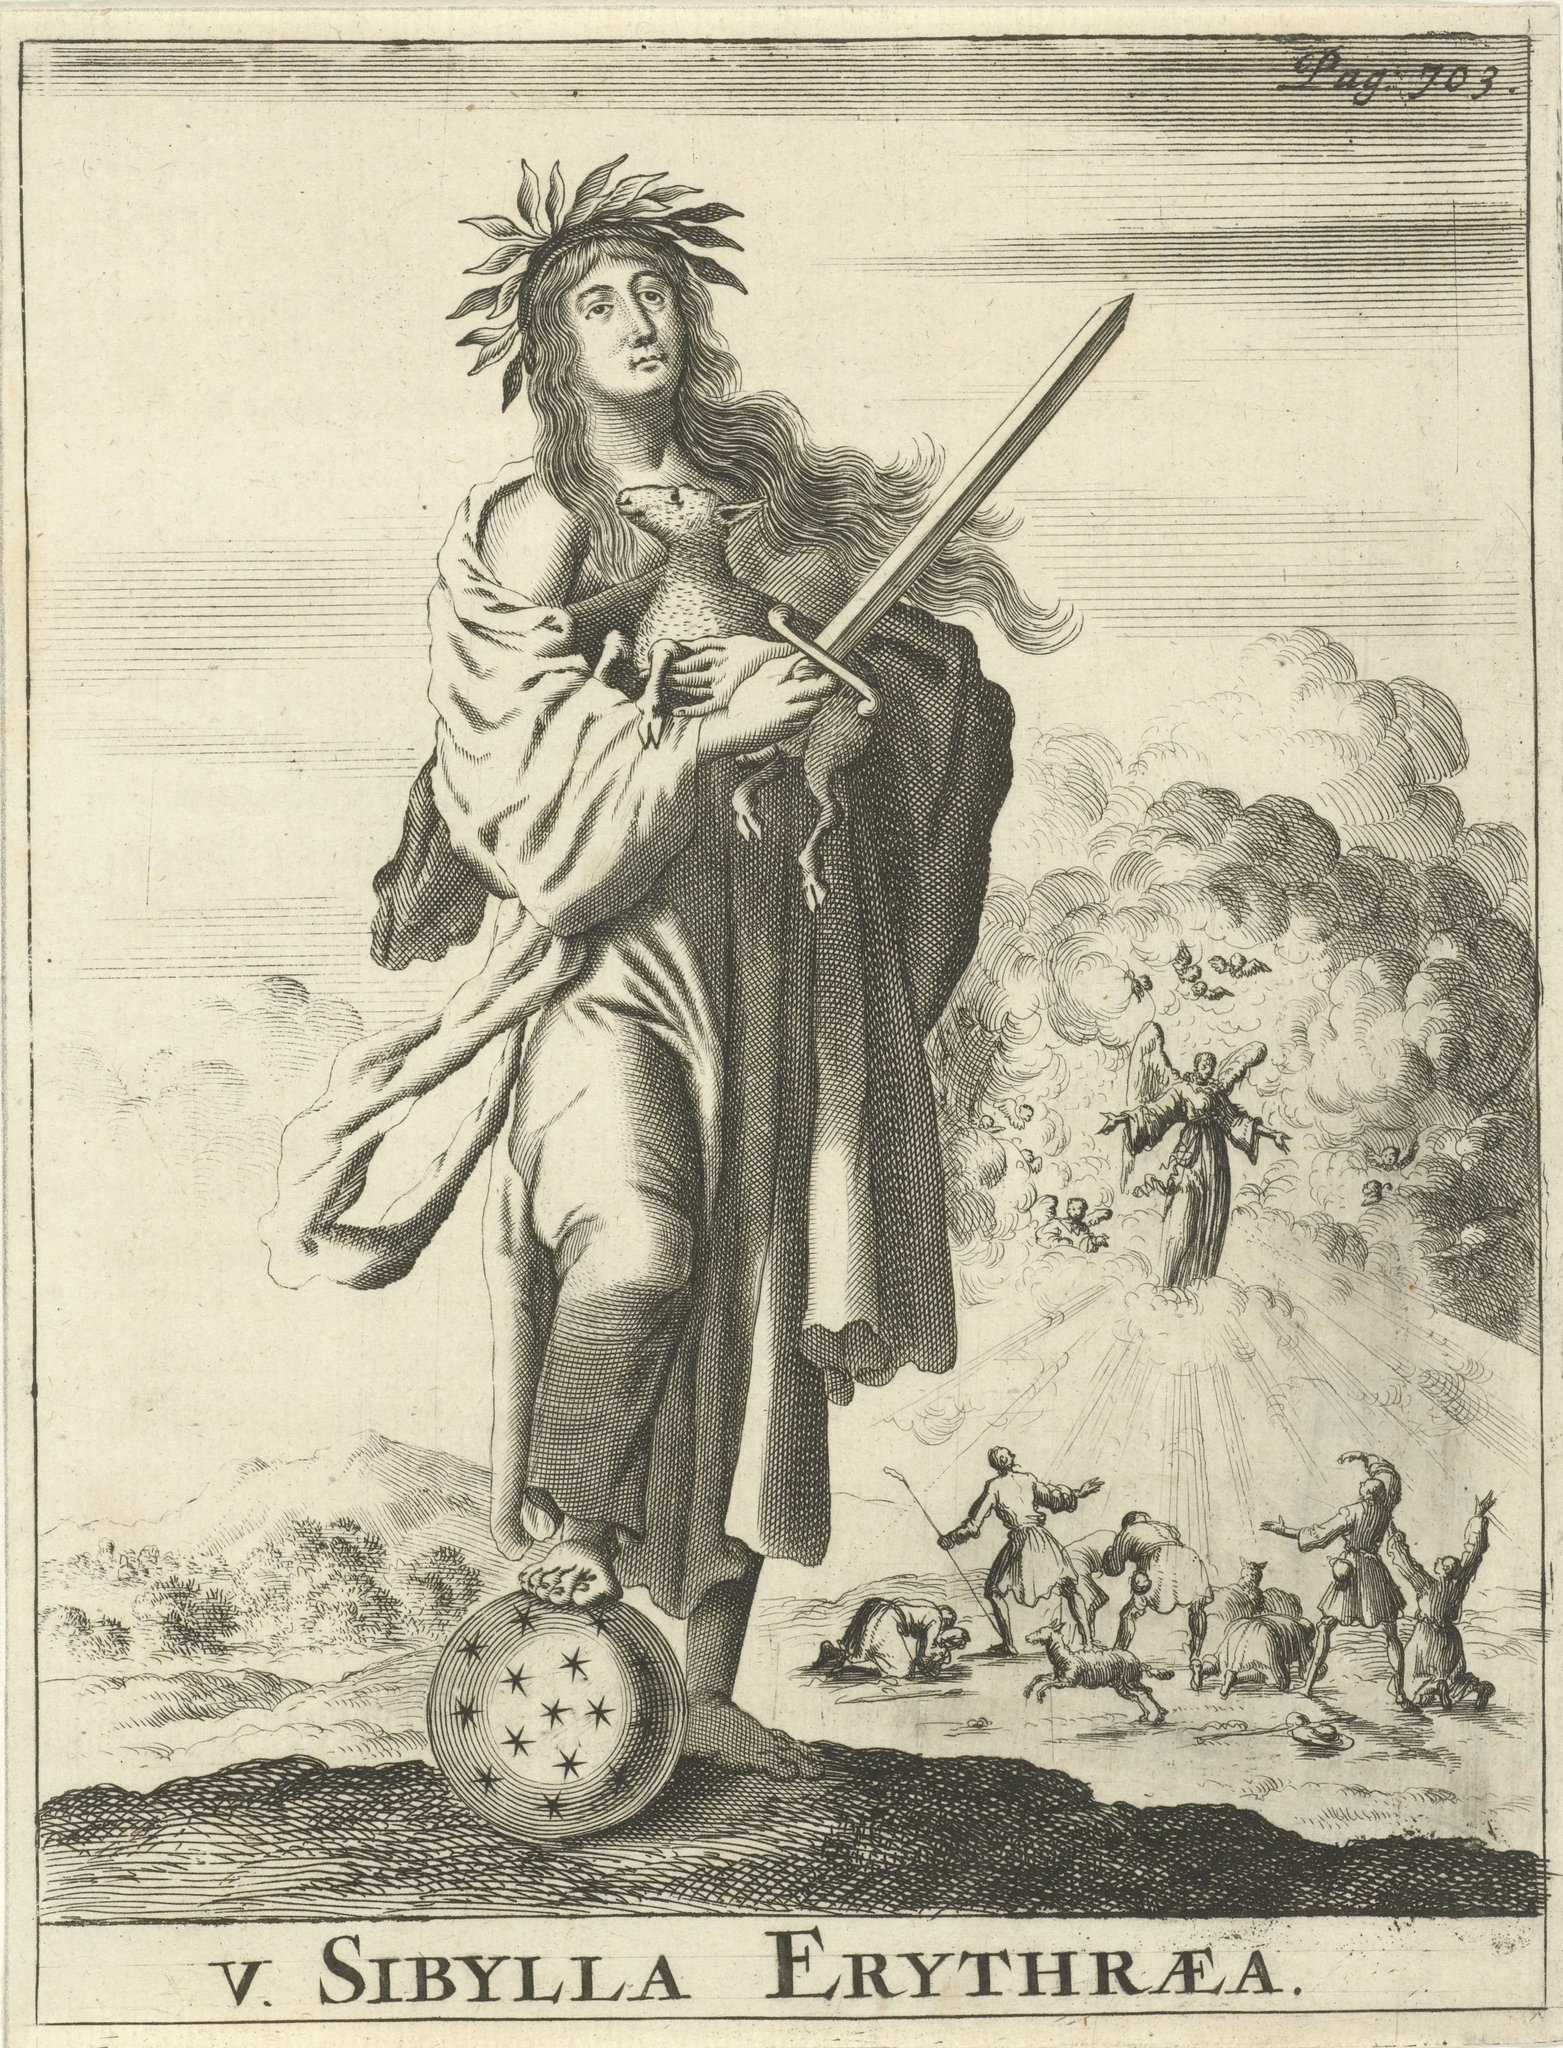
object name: book illustration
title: Sibylla Erythraea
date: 1684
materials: paper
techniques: engraving, etching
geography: amsterdam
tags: annunciation of christ's birth to the shepherds (and/or shepherdesses) at night; a host of singing angels in the air, erythraean sibyl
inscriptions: collector's mark: Lugt 2228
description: Sibille van Erythrae. Op de achtergrond de verbeelding van de verkonding aan de herders. Prent rechtsboven gemerkt: Pag: 703.